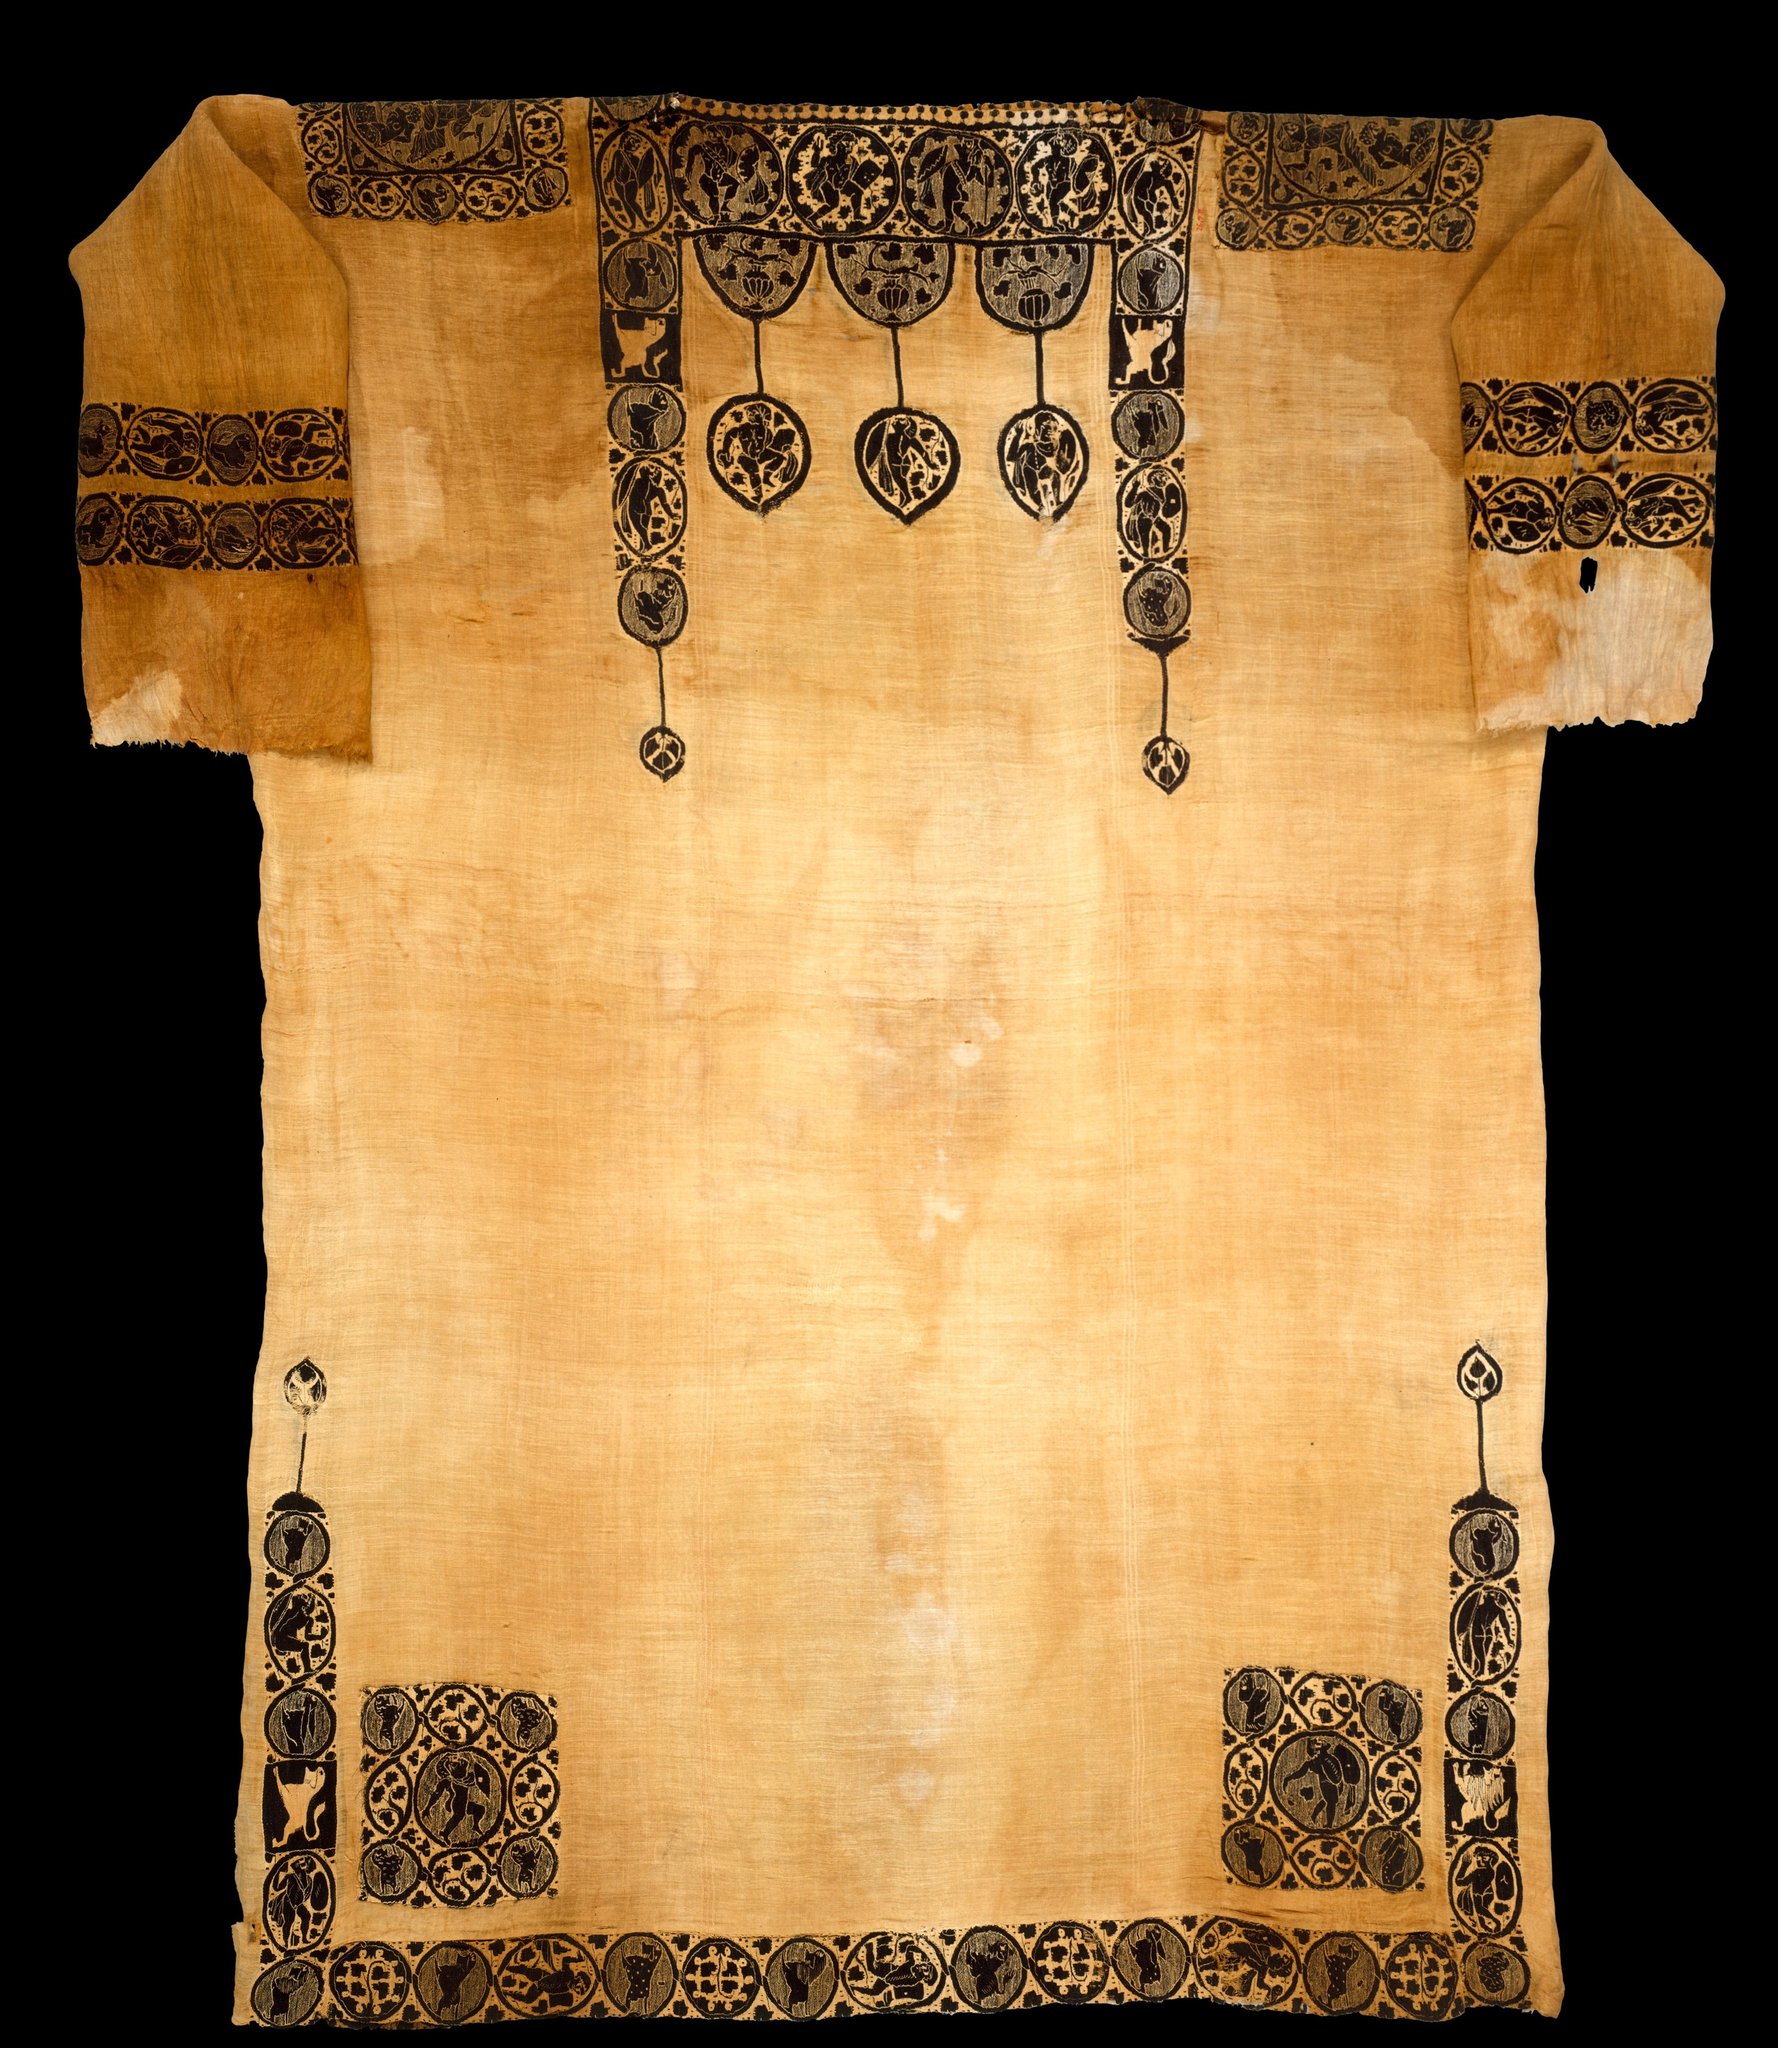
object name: tunic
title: Tunic with Dionysian Ornament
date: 401-500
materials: linen, wool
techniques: weave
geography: egypt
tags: dionysus